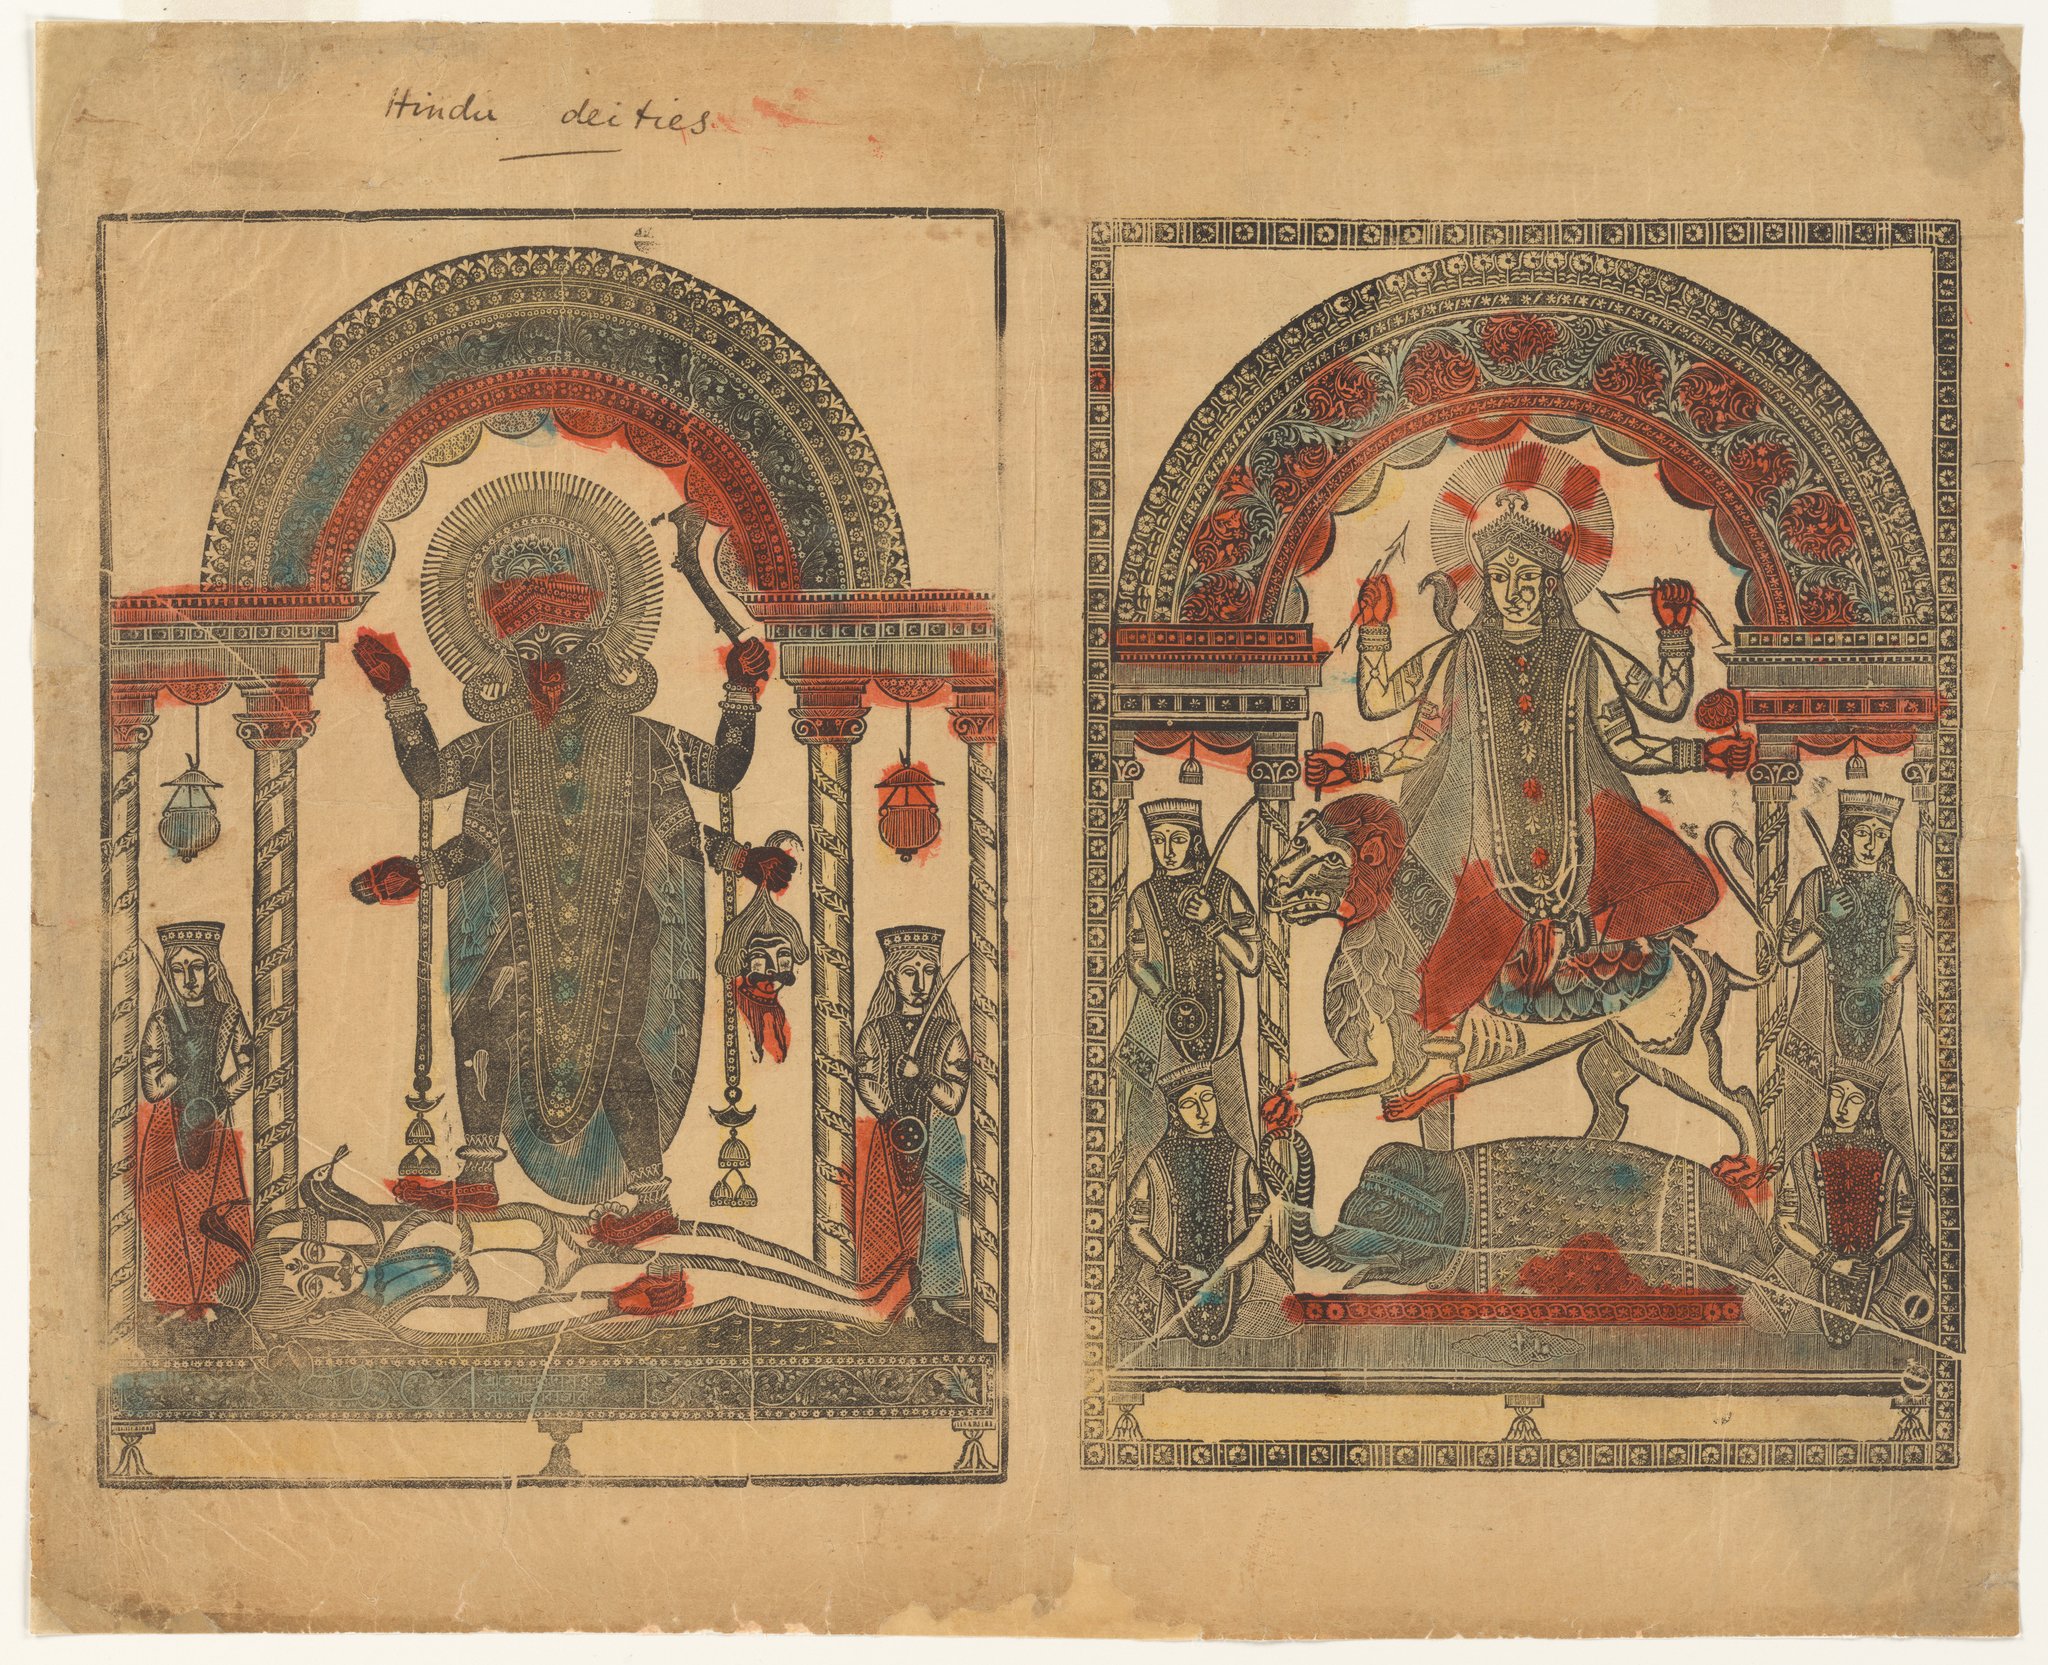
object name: print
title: The goddesses Kali and Jagadhatri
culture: indian, west bengal, kalighat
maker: sri hemchandra das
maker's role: artist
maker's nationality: indian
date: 1850-1870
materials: metal, watercolor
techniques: hand coloring, printing, relief